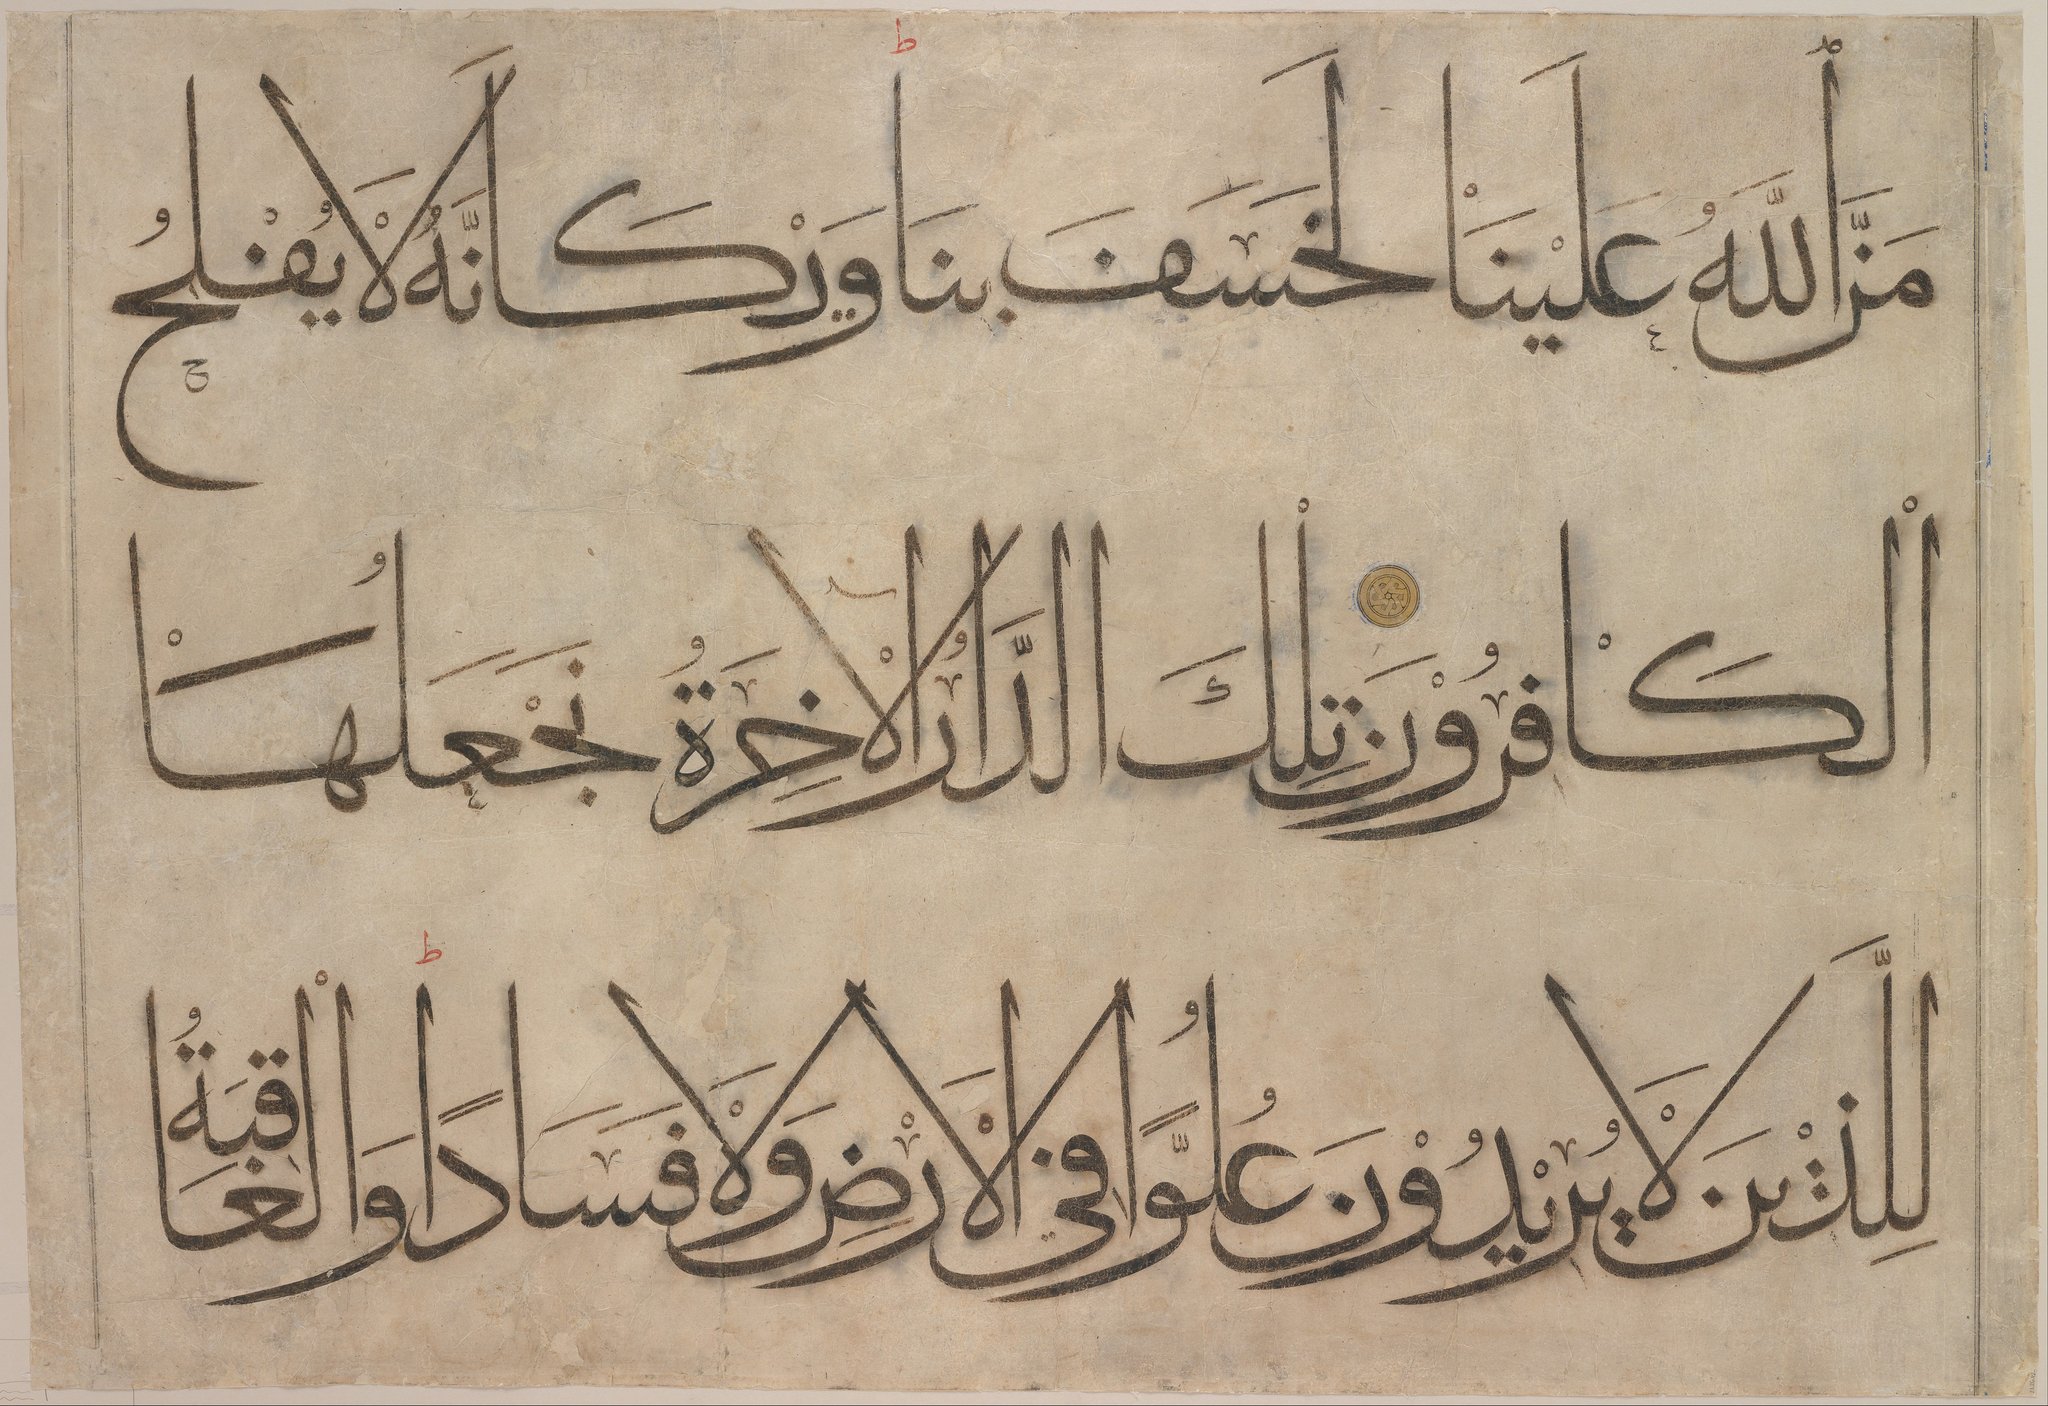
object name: section from a non illustrated manuscript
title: Section from a Qur'an Manuscript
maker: `umar aqta'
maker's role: calligrapher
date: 1367-1433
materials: gold, ink, paper, watercolor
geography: uzbekistan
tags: arabic,qur'an,calligraphy